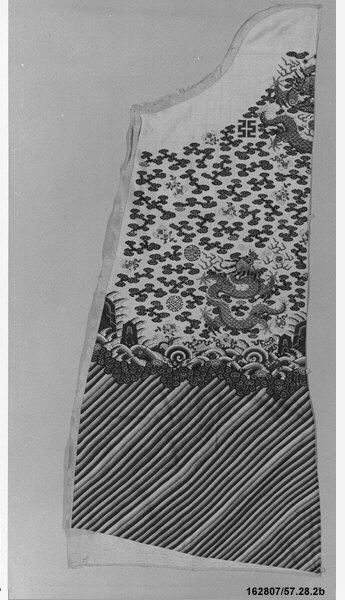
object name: robe, emperor's 12 symbol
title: Pieces for Emperor's Twelve-Symbol Robe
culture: chinese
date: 1867-1900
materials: silk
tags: dragons